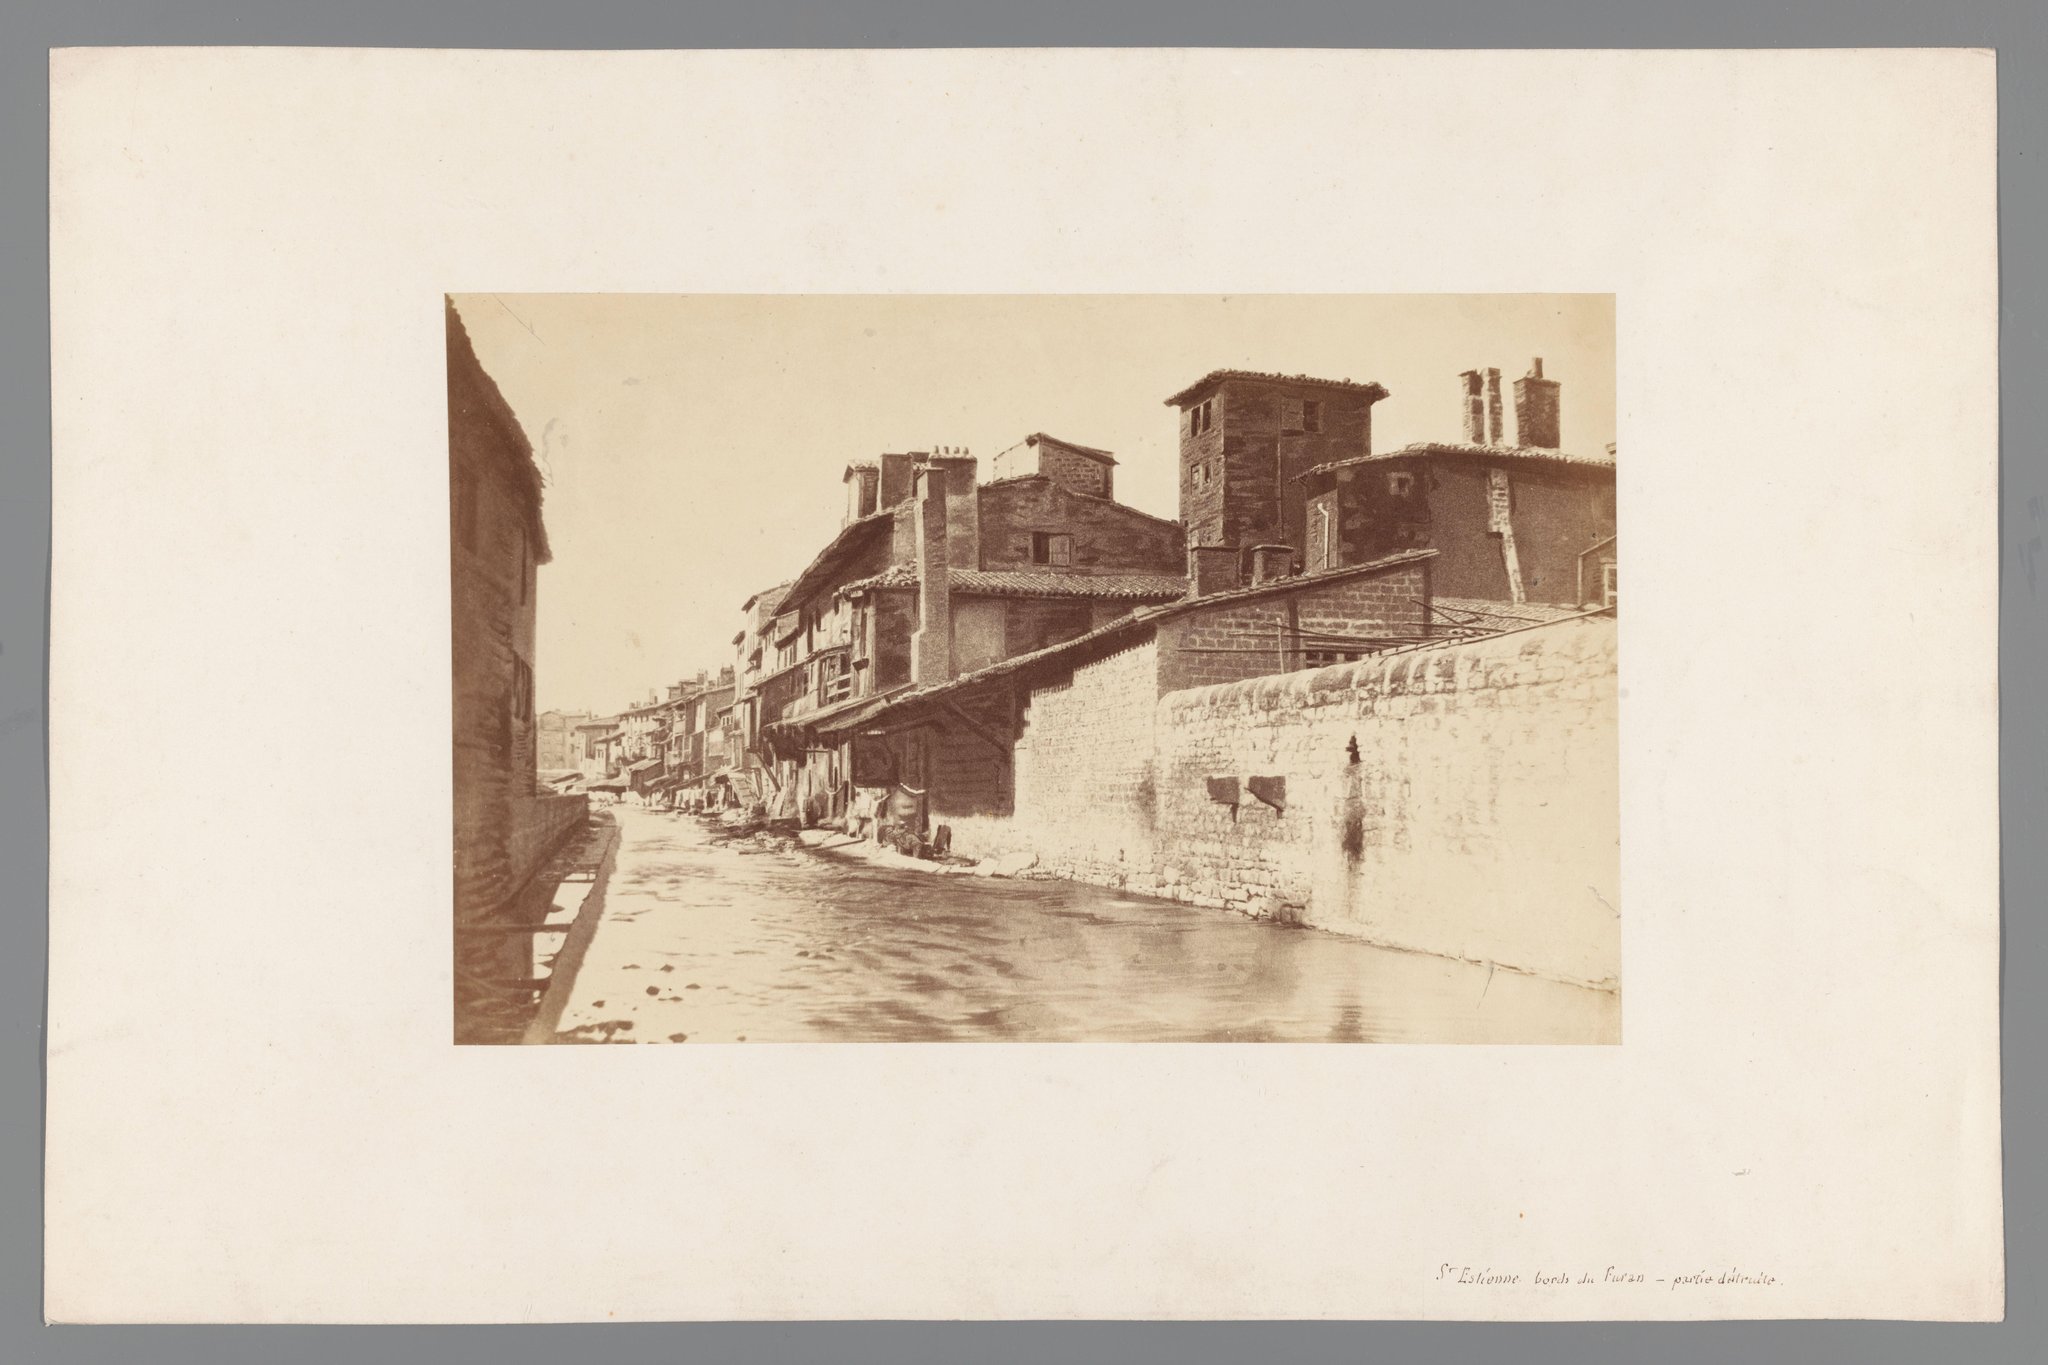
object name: photograph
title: Overstroming van de Furan in Saint-Étienne, ‘parti détruite'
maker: Anonymous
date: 1860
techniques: albumen print